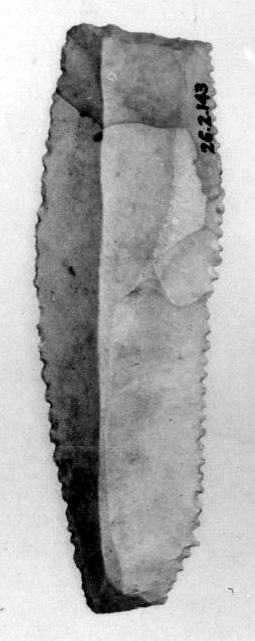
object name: tool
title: Tool (?)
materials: stone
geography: egypt